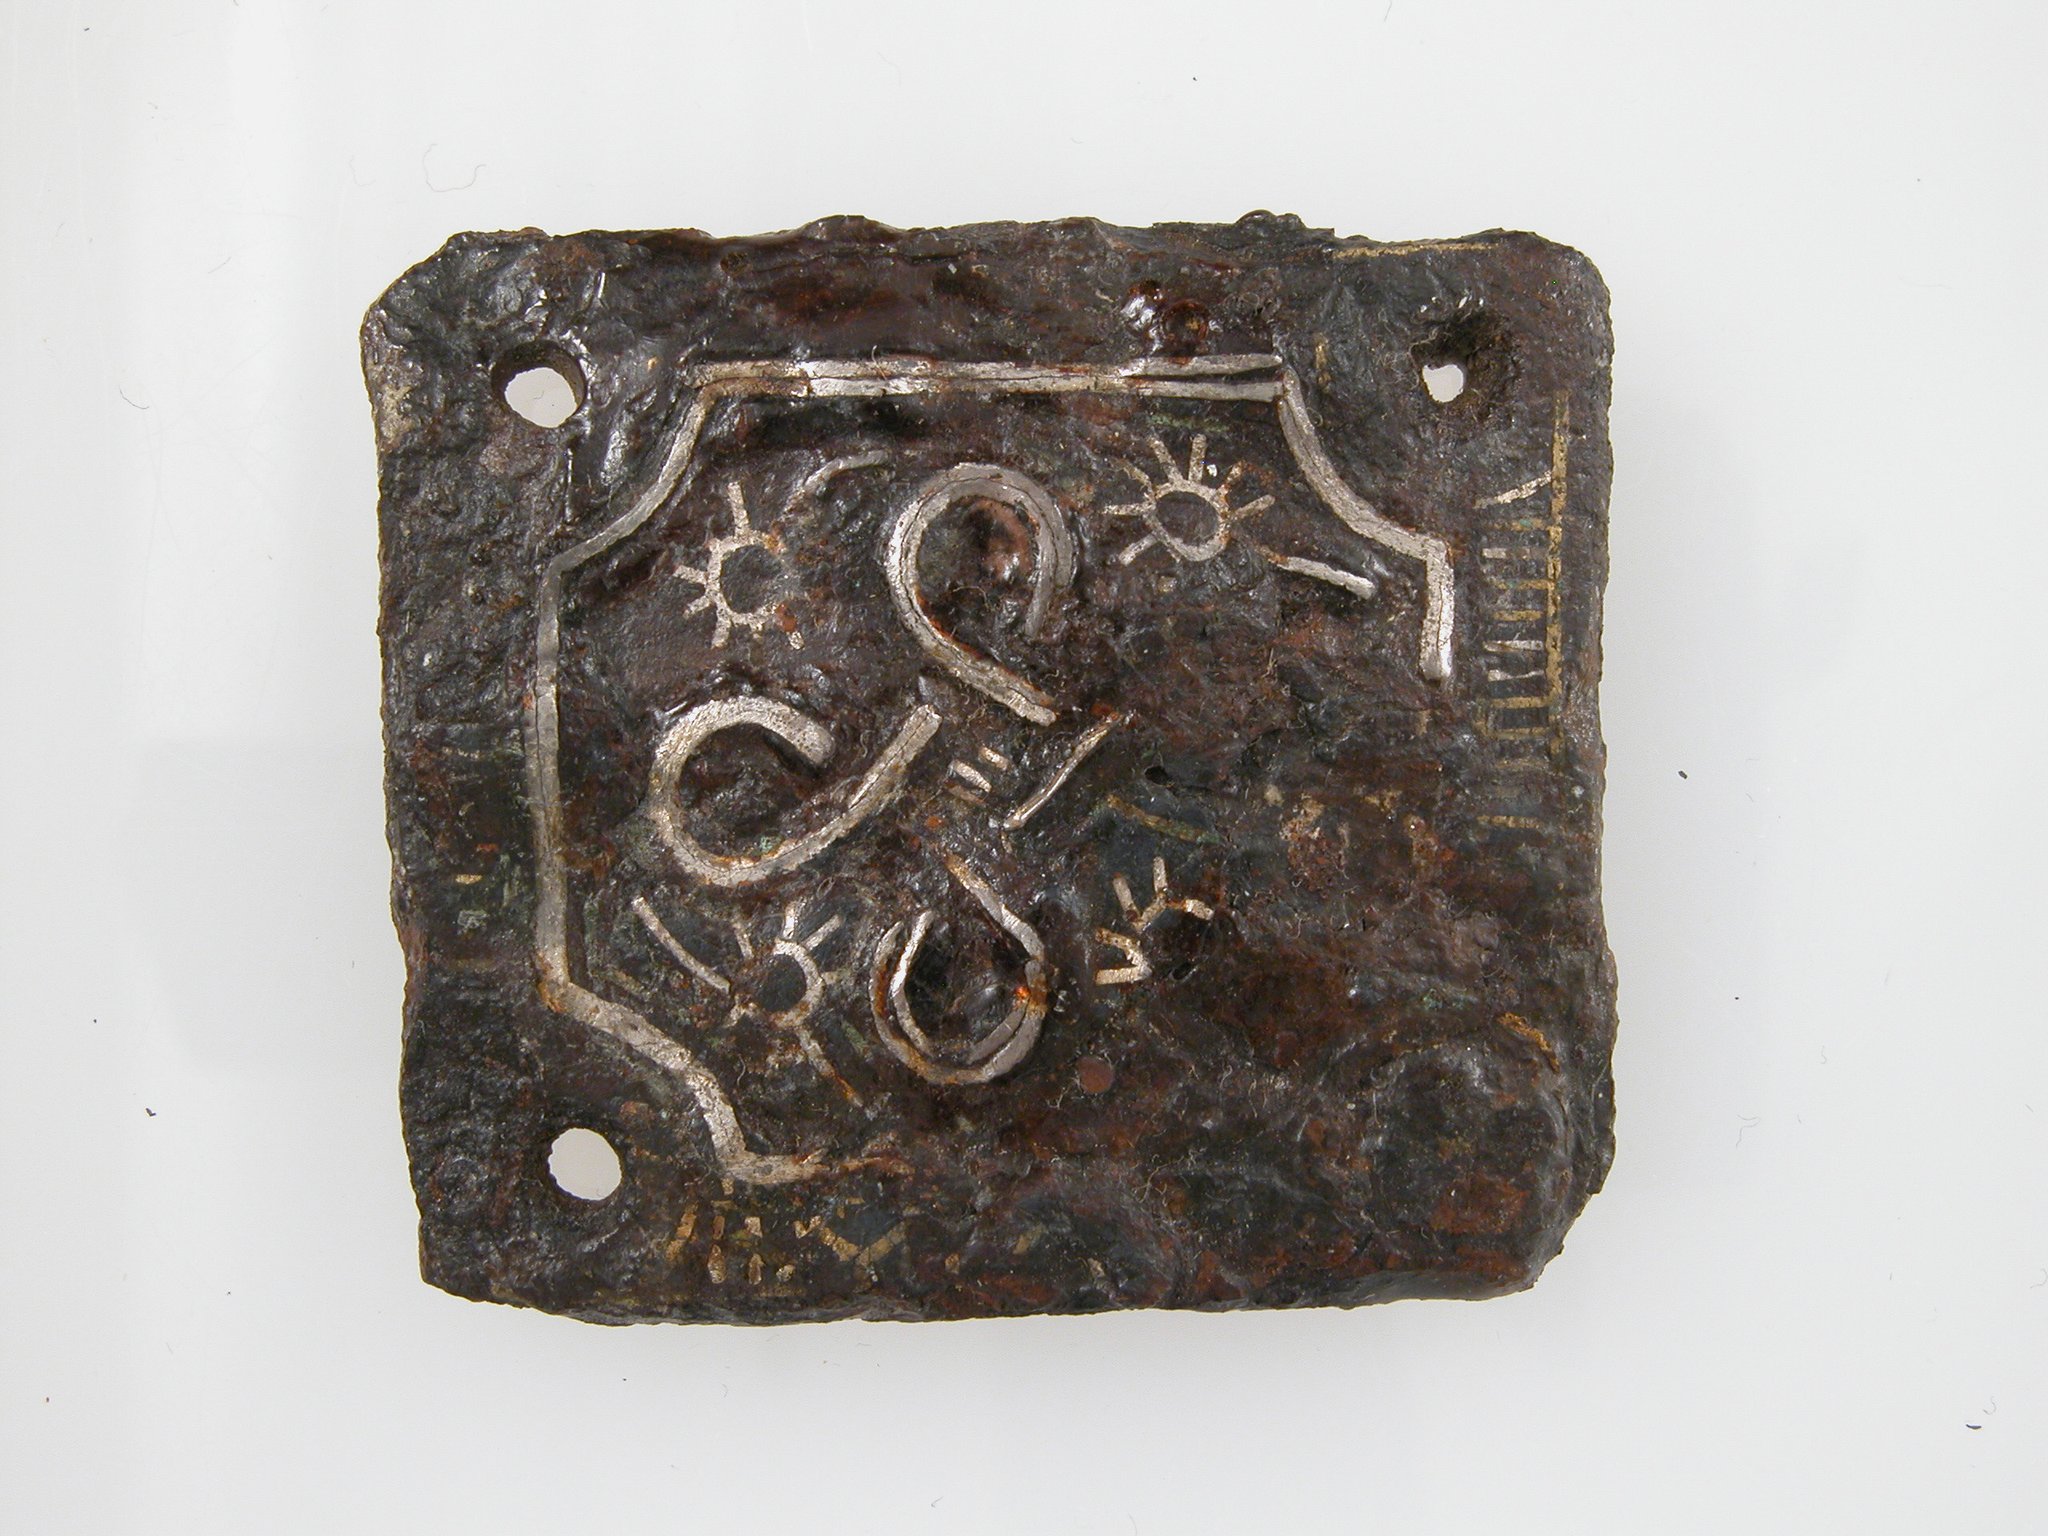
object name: belt plate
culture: frankish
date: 601-700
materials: brass, iron, silver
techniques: inlay